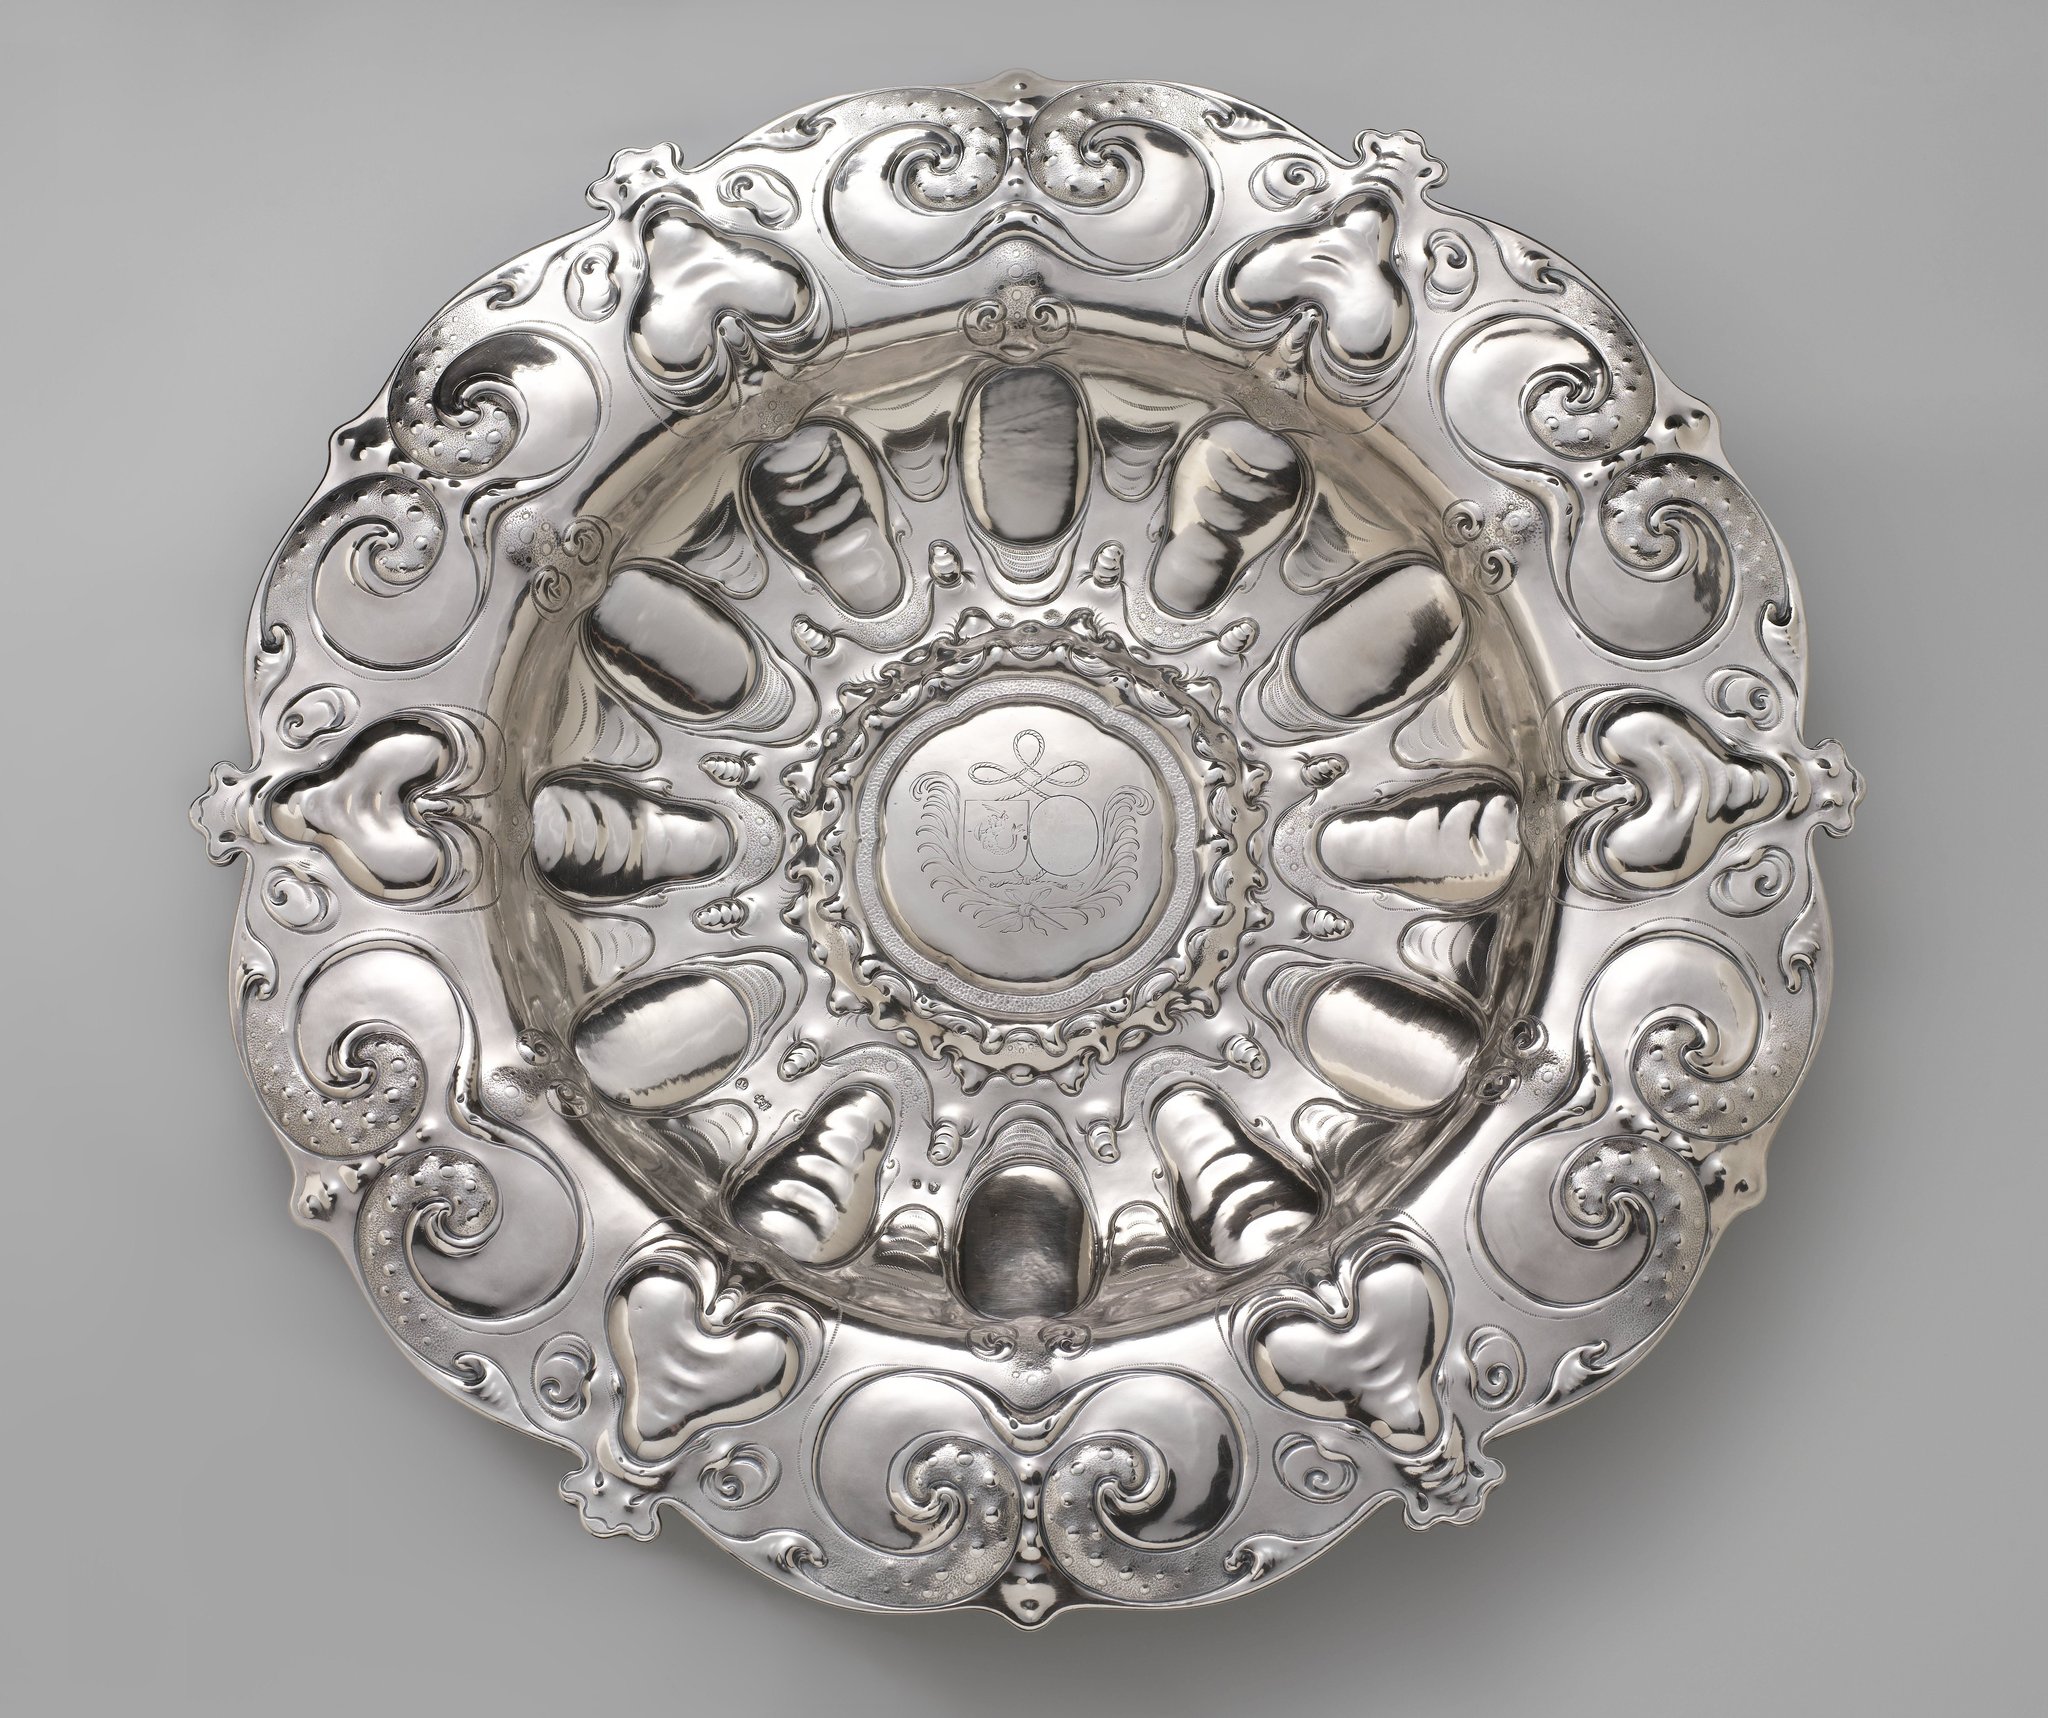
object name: dish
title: Basin and ewer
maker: andries grill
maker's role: jeweler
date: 1649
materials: silver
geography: the hague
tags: auricular ornament, lobe style ~ ornament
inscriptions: mark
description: This basin and ewer were made for the Delft councillor Gerard Meerman. They are engraved with two escutcheons, one for Meerman and the other for his wife. However, only his shield is filled in. The celebrated Hague silversmith Grill executed the objects in a personal interpretation of the so-called Auricular style, placing emphasis on abstract linear forms.